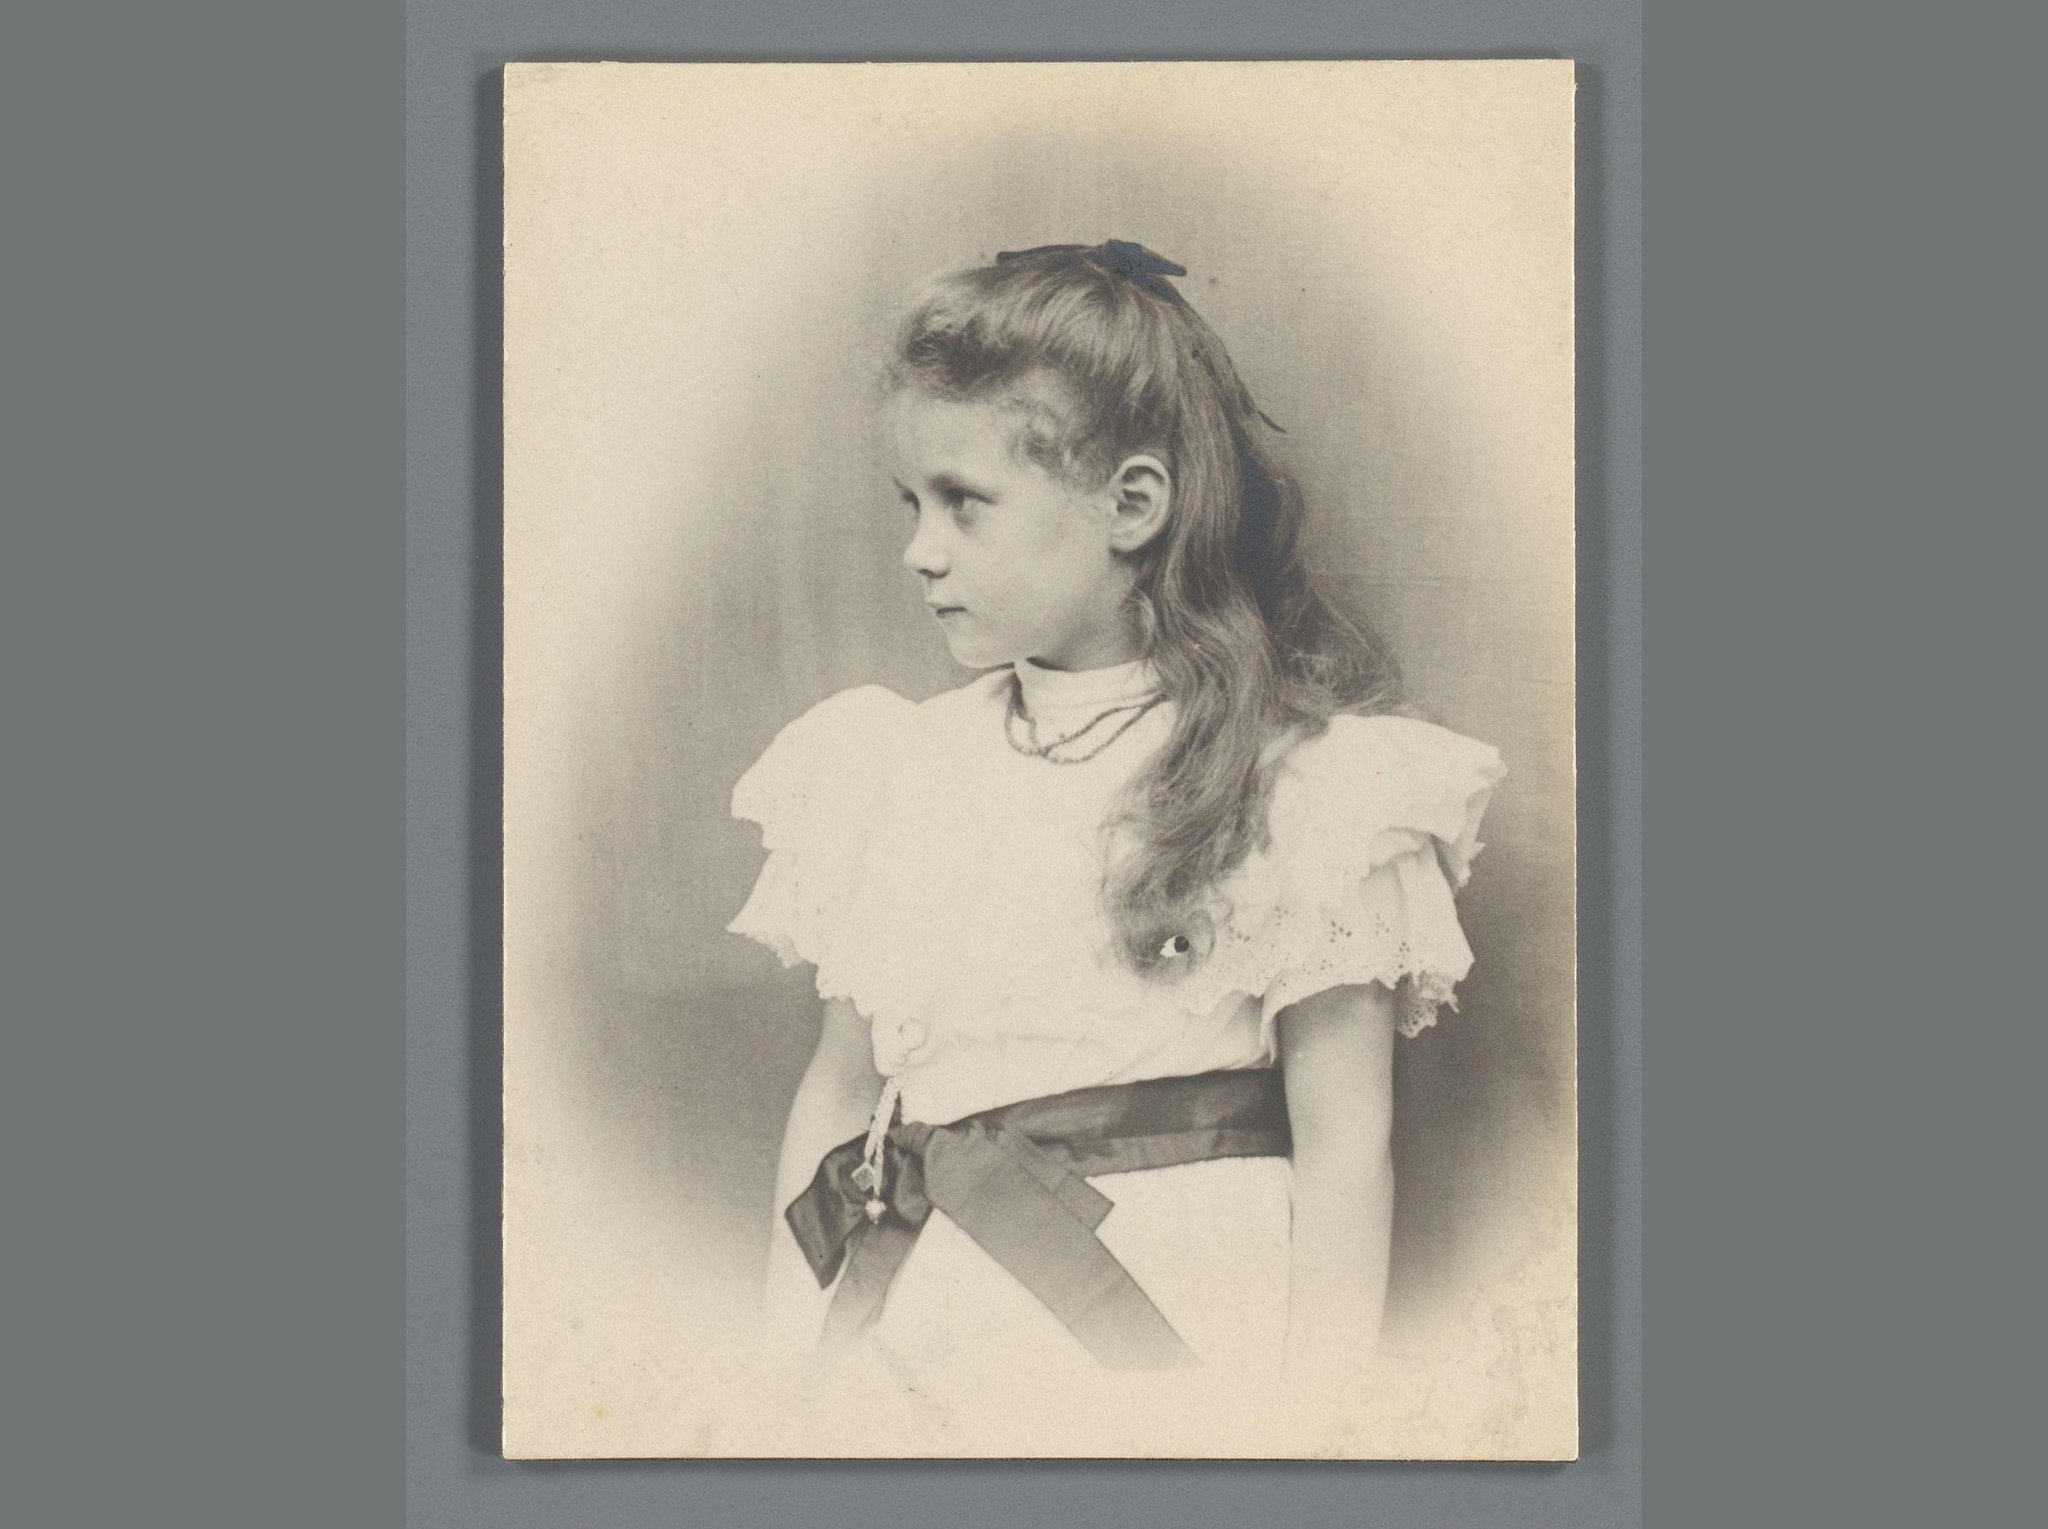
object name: photograph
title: Portret van Johanna (Hans) de Jong als kind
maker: Anonymous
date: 1903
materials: cardboard, photographic support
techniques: matte daylight collodion silver print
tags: johanna petronella lambertina stokhuyzen-de jong (hans), historical persons - bb - woman, girl (child between toddler and youth)